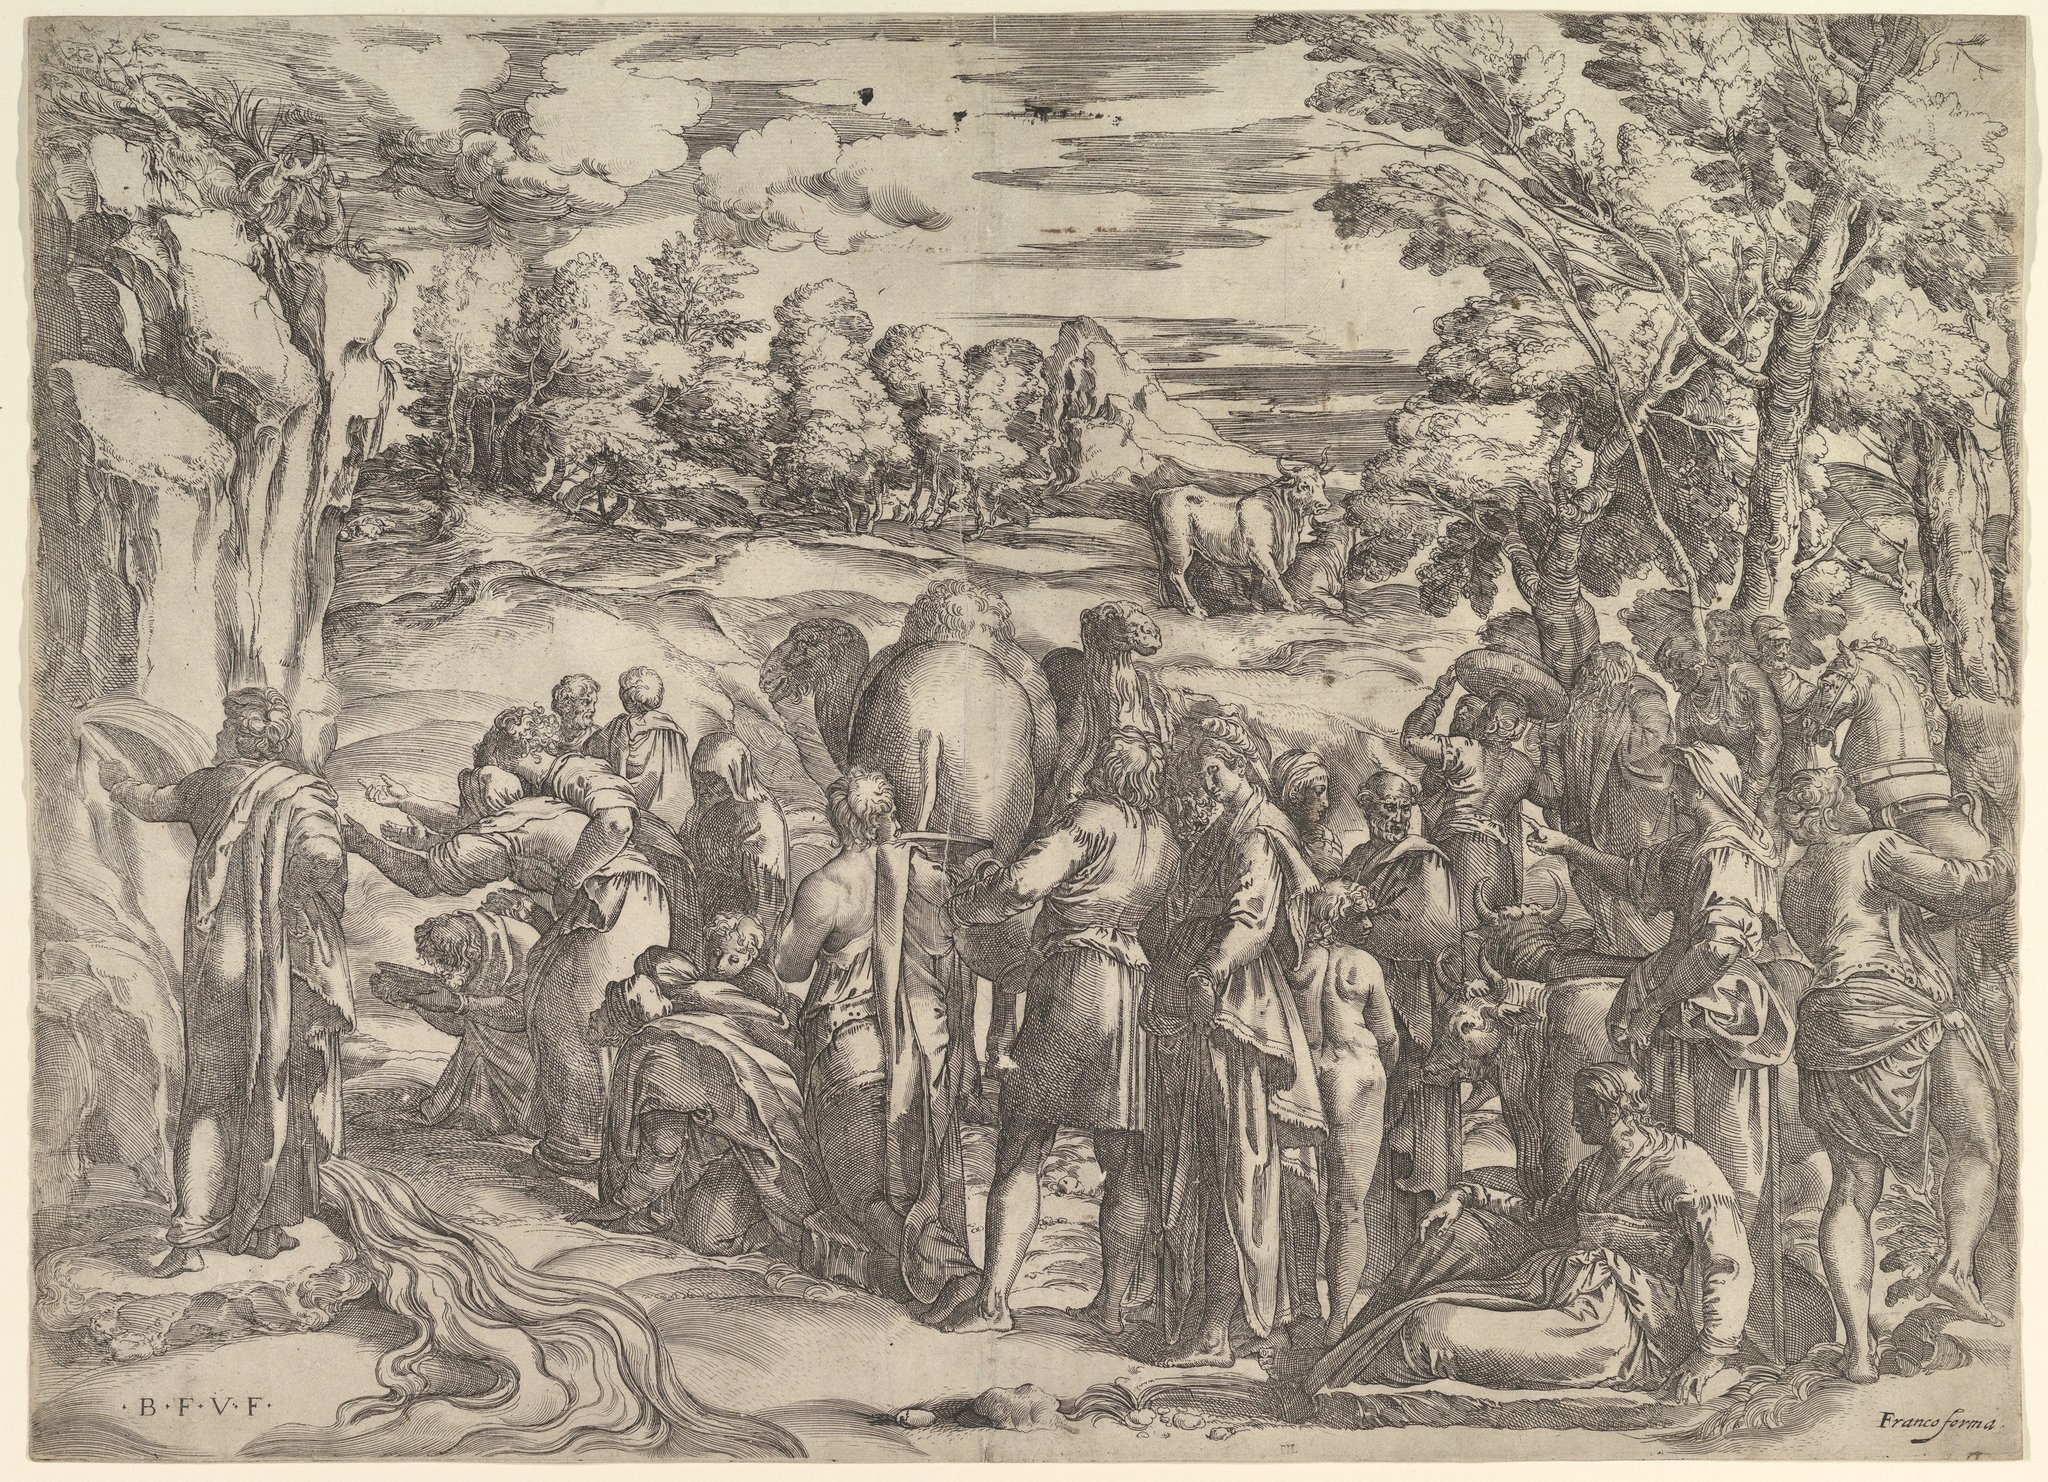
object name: print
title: Moses Drawing Water from the Rock, at left with water flowing, various figures and animals waiting at right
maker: battista franco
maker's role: artist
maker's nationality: italian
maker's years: 1510-1561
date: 1552-1561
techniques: engraving, etching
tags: animals,men,trees,moses,crowd